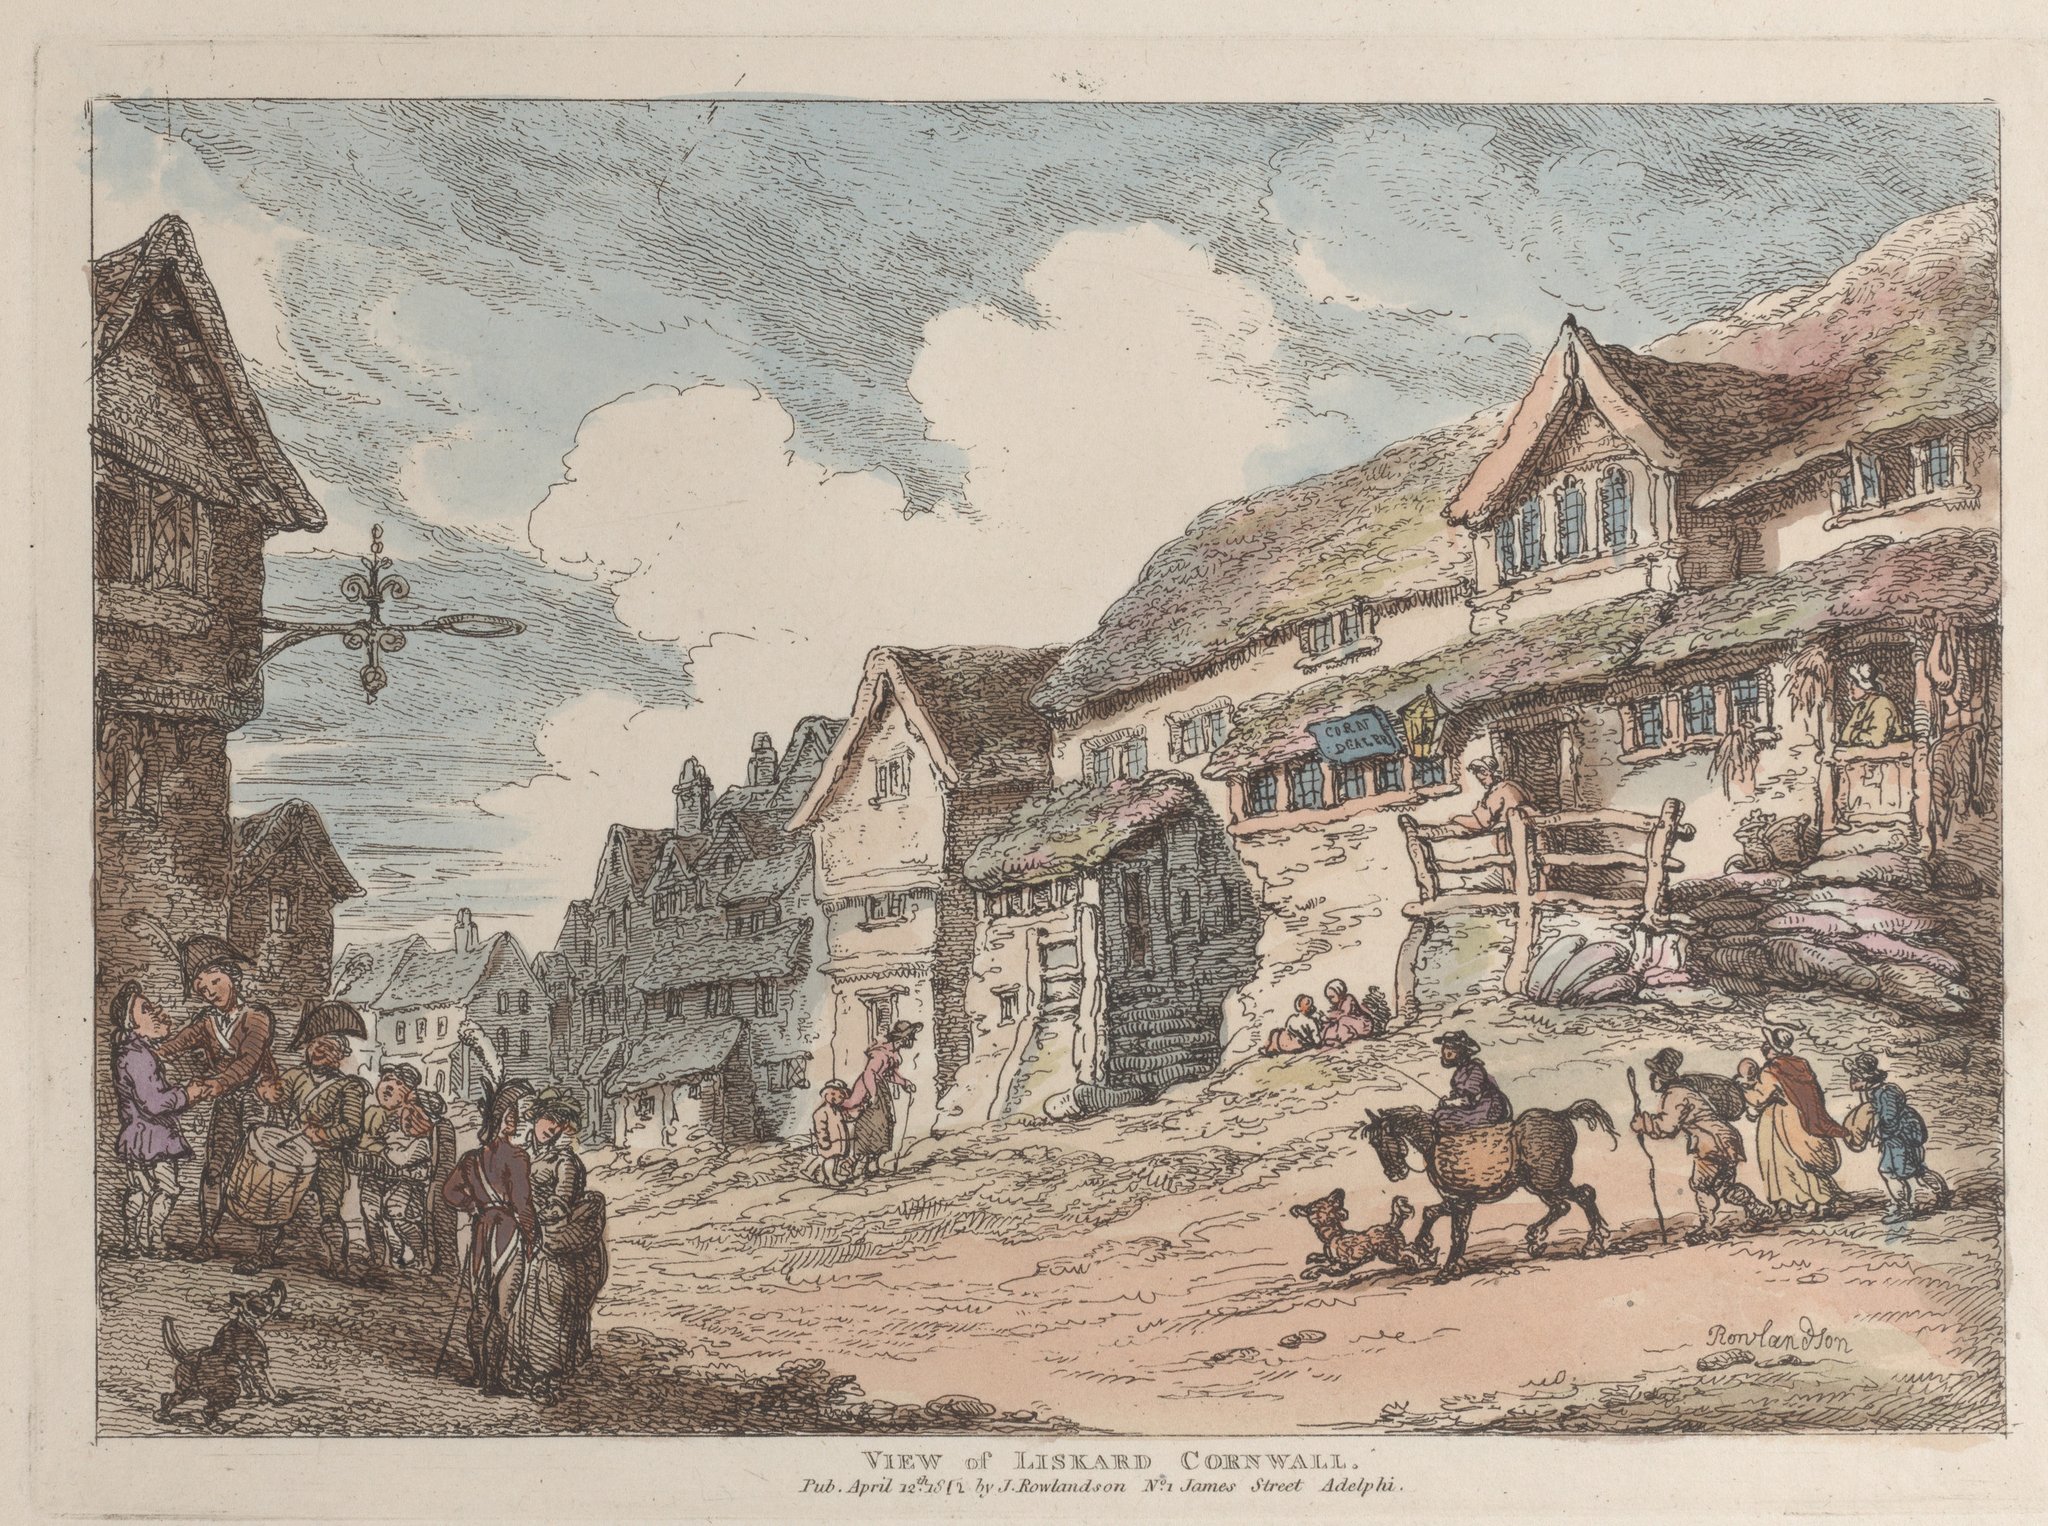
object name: print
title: View of Liskard, Cornwall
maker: thomas rowlandson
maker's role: artist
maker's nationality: british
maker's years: 1757-1827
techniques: etching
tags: buildings,towns